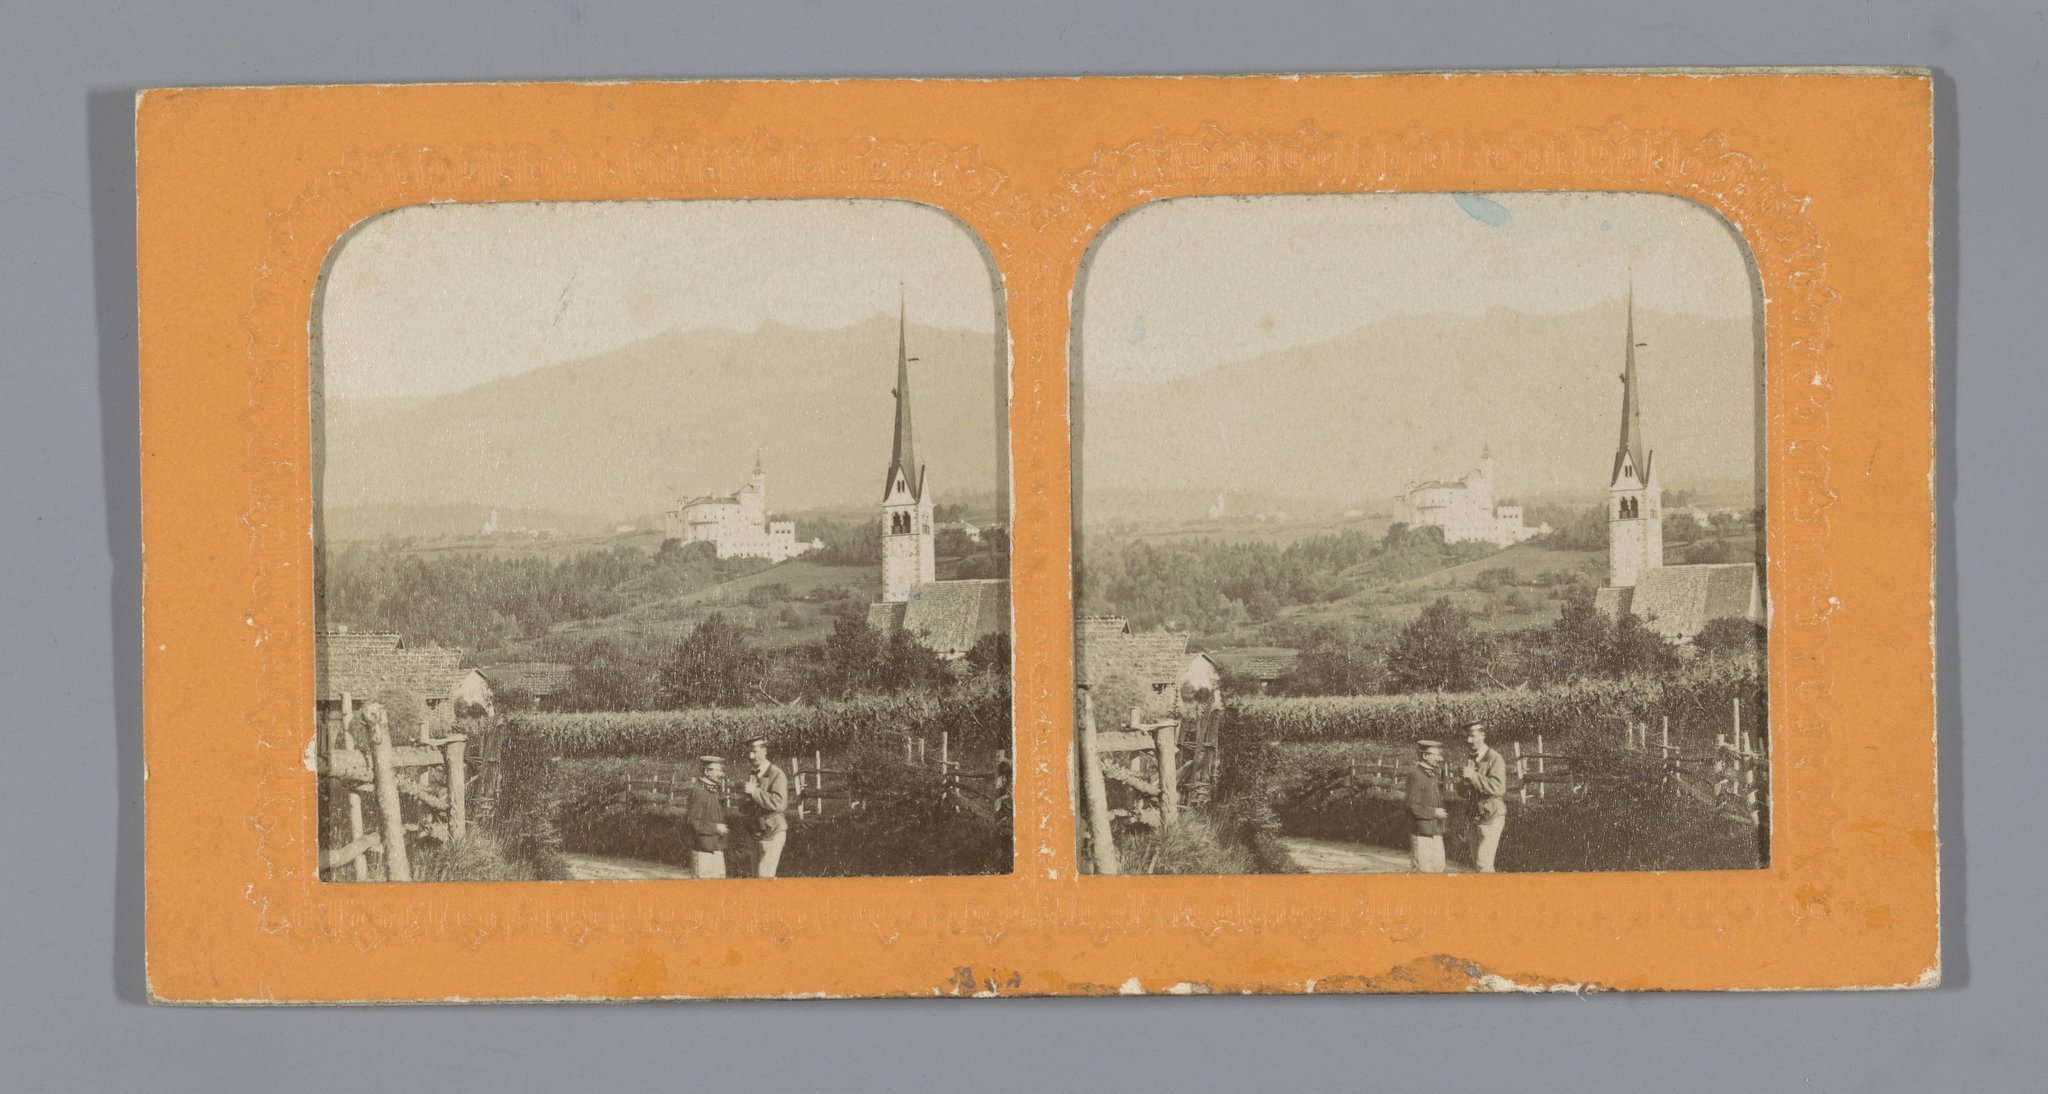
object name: tissue stereograph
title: Gezicht op Amras, Tirol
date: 1855-1875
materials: cardboard, paper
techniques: albumen print, hand coloring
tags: church (exterior), landscape with tower or castle, mountains